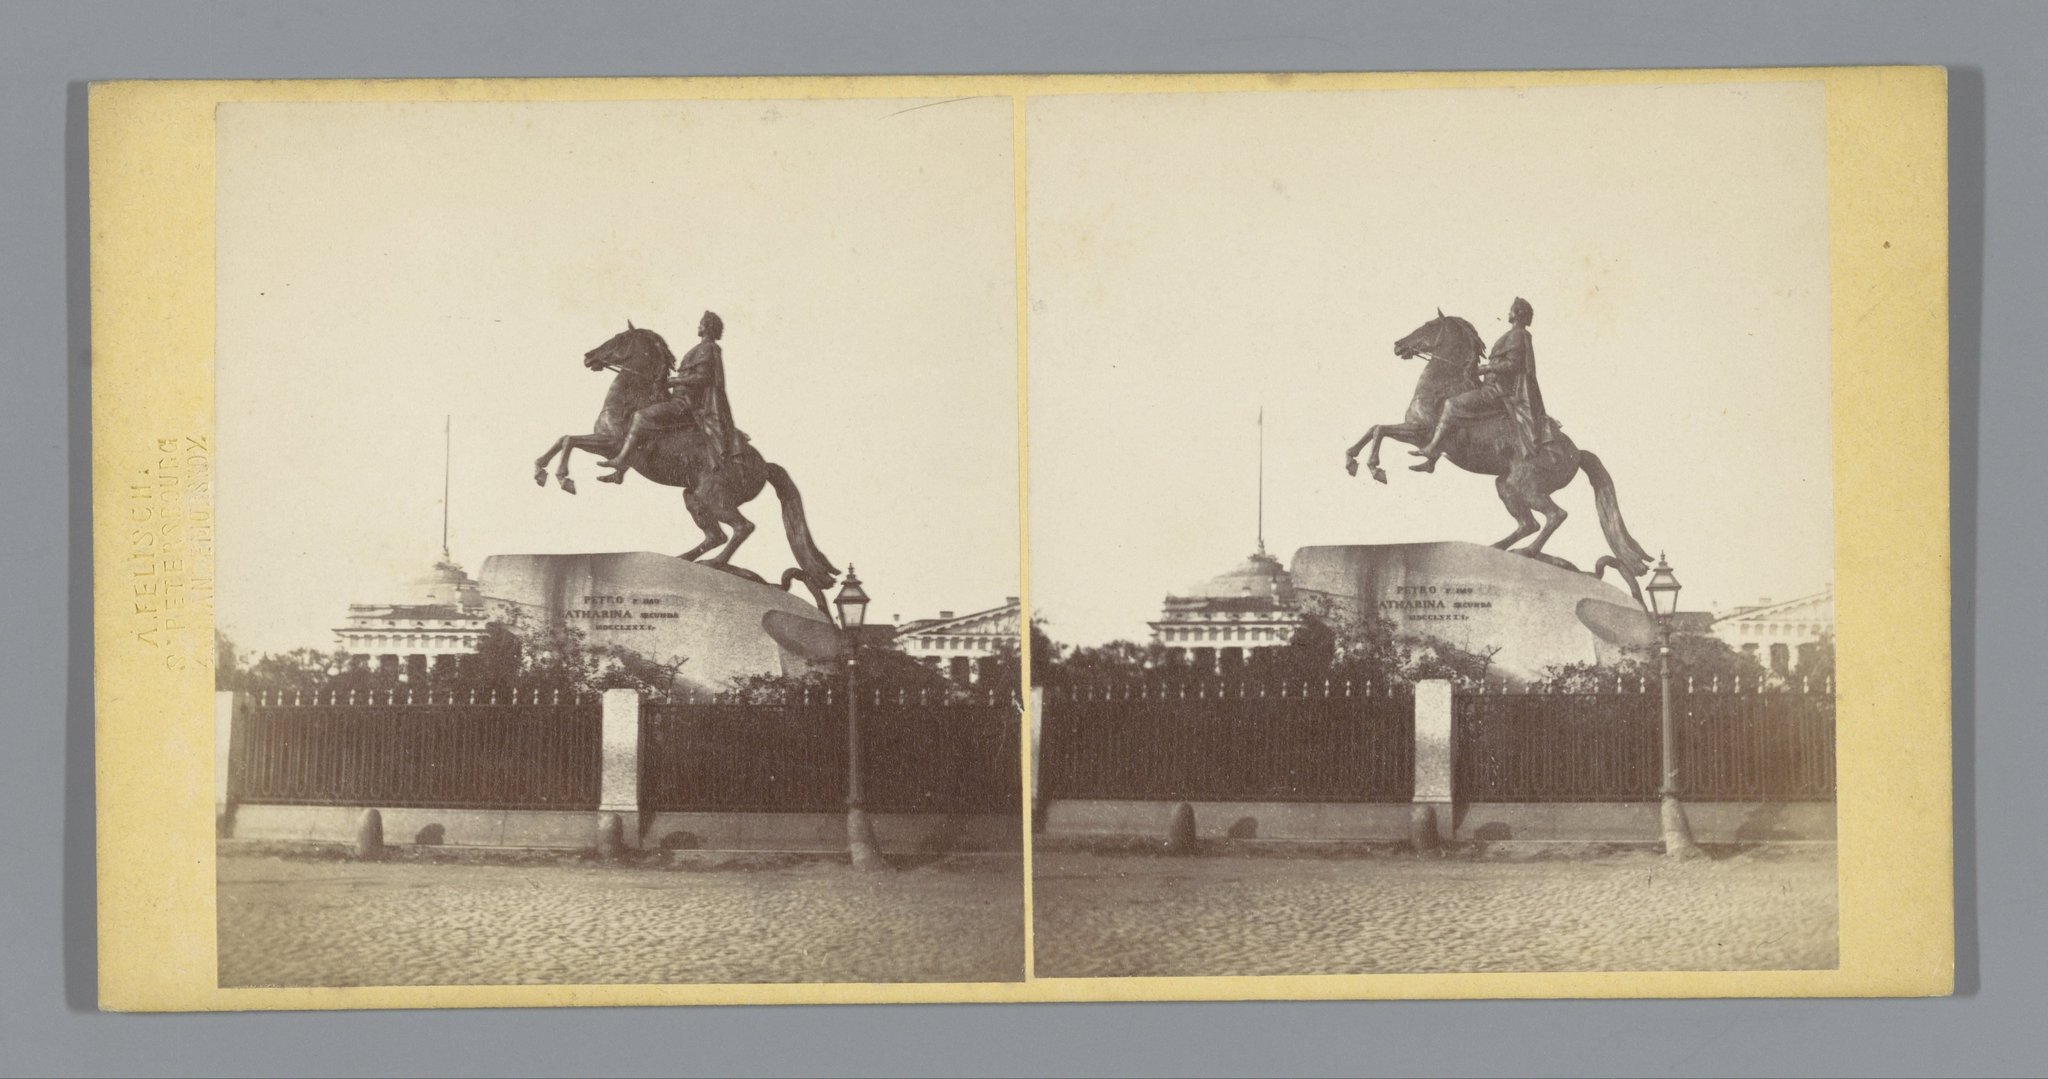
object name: stereograph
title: Ruiterstandbeeld van Peter de Grote I in Sint-Petersburg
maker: albert felisch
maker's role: fotograaf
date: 1850-1880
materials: cardboard, photographic support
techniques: albumen print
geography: sint-petersburg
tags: equestrian statue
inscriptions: name: ‘A. FELISCH. S. PETERSBOURG 42. GRANDEMORSKOY.’, inscription: ‘St. Petersburg Monument Peter I’